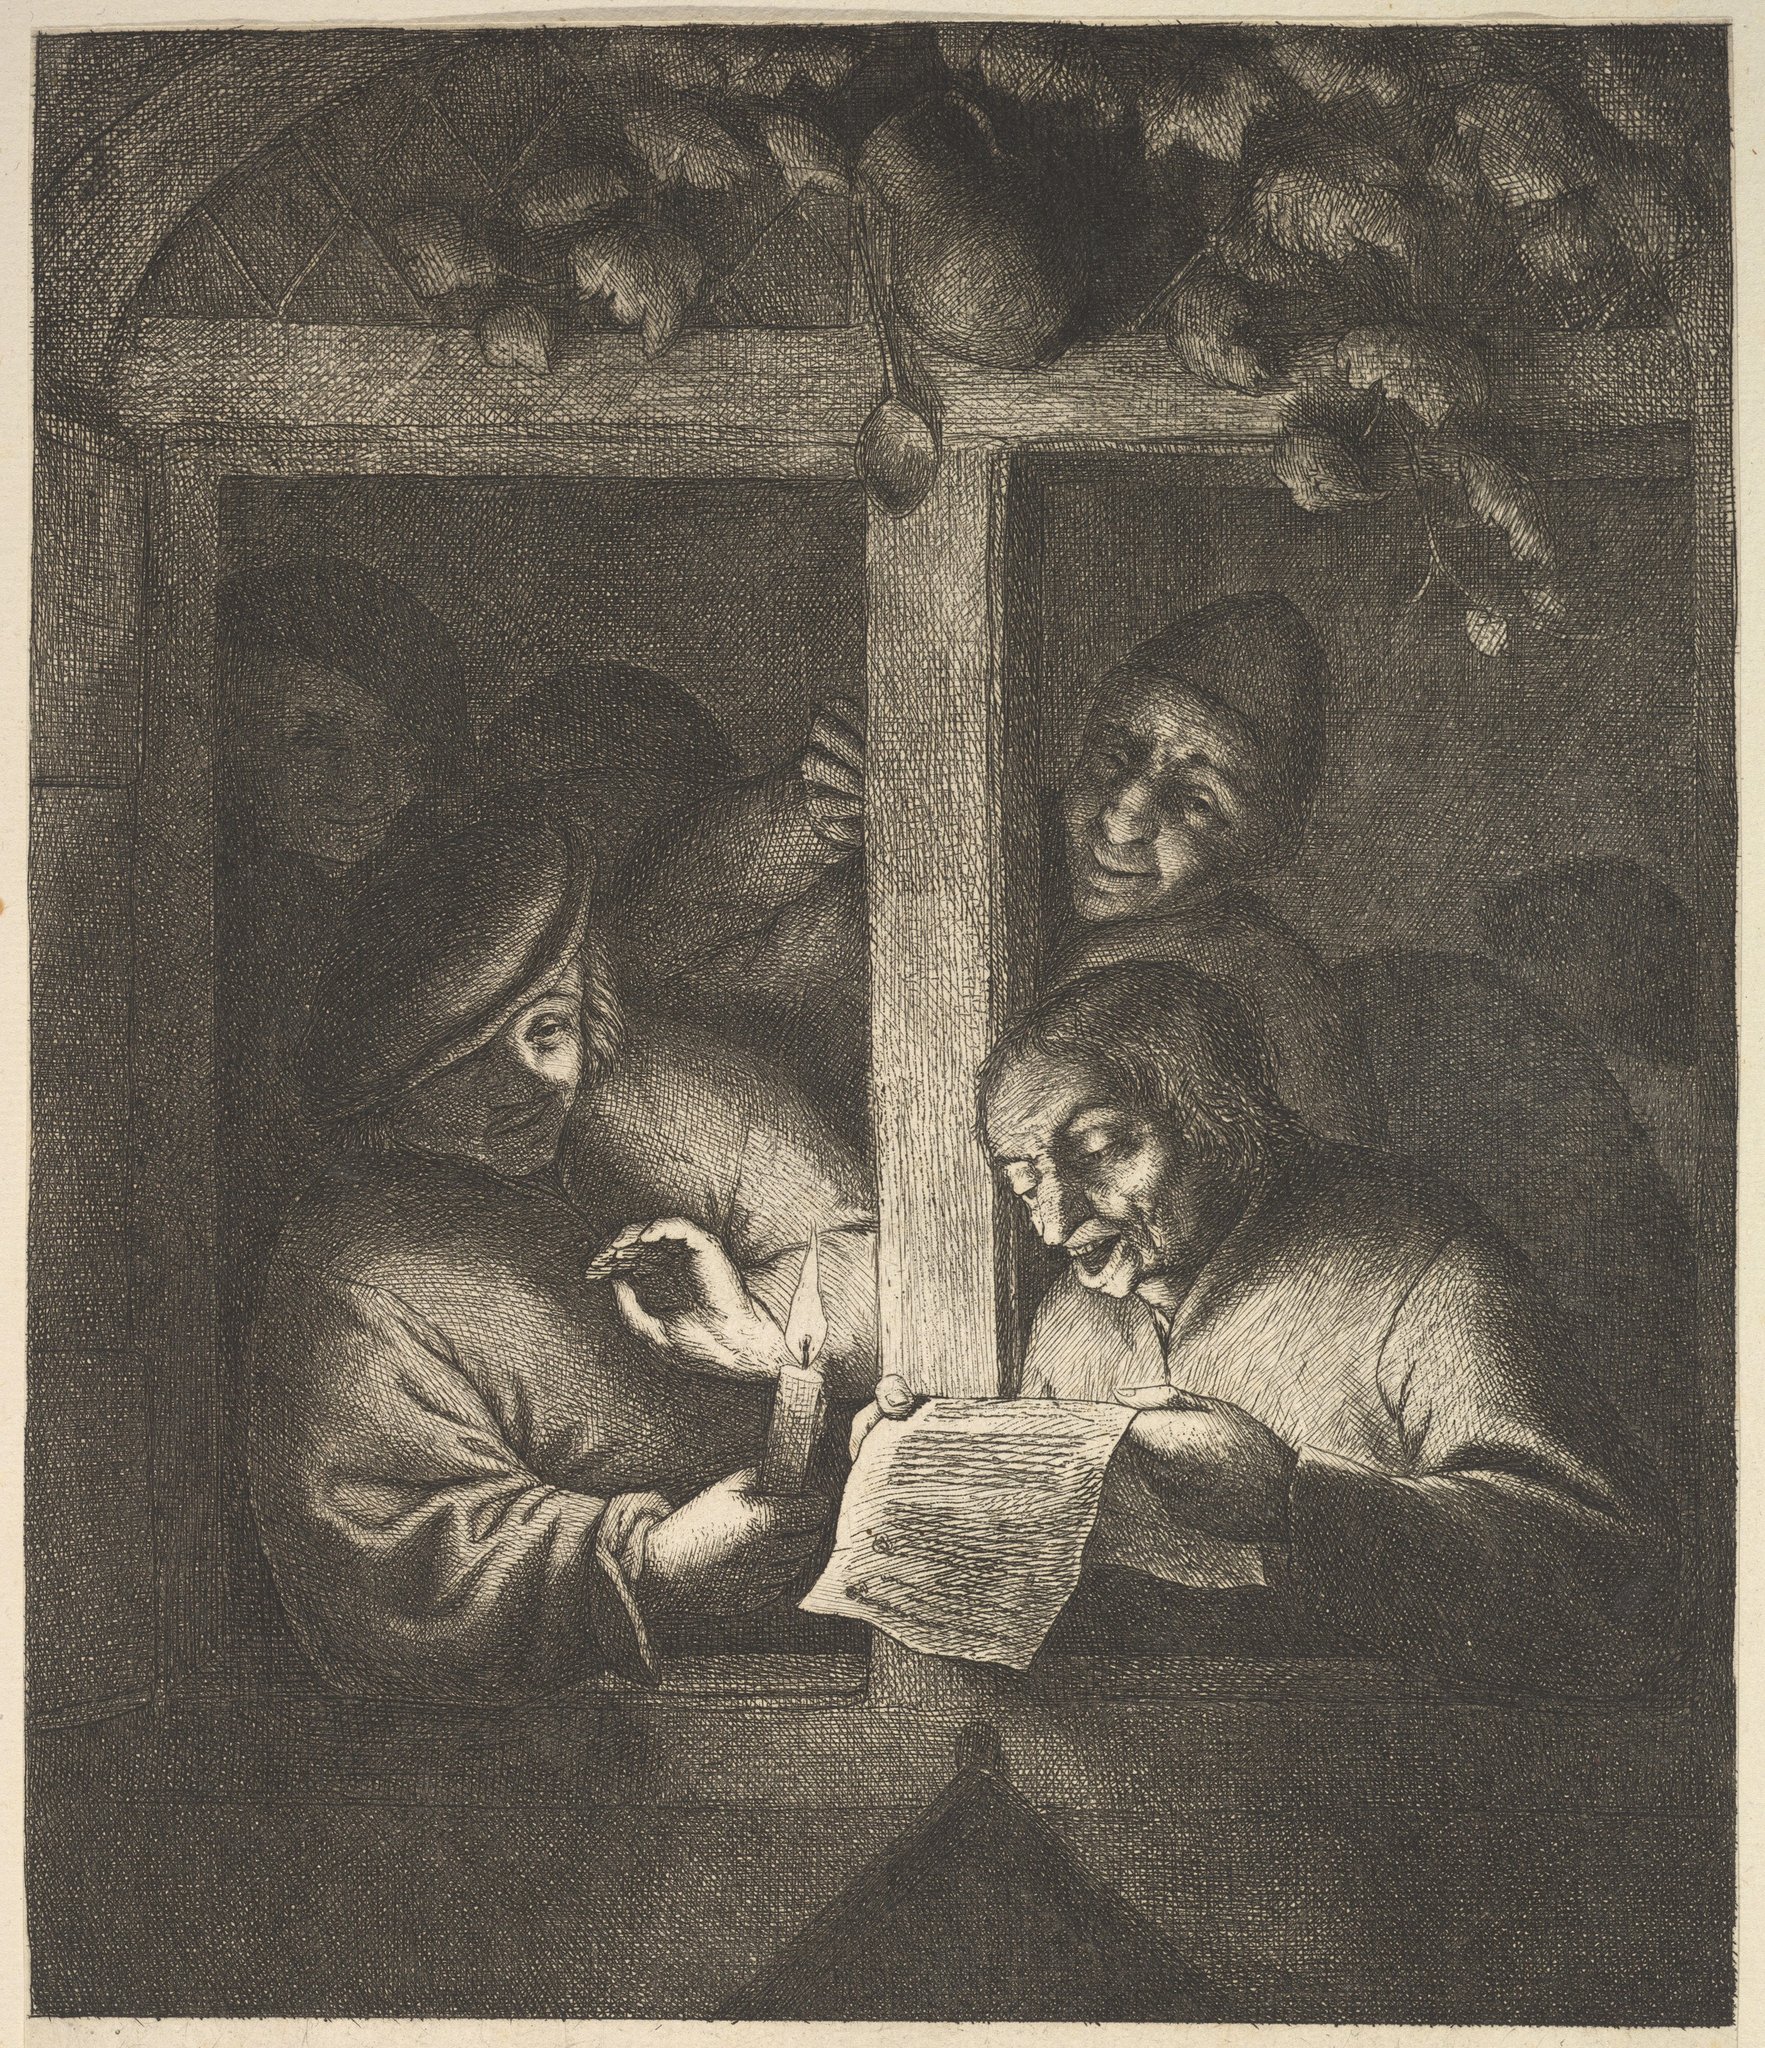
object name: print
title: Singers at the Window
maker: adriaen van ostade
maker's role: artist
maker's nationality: dutch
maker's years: 1610-1685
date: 1610-1685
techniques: etching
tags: windows,men,singers